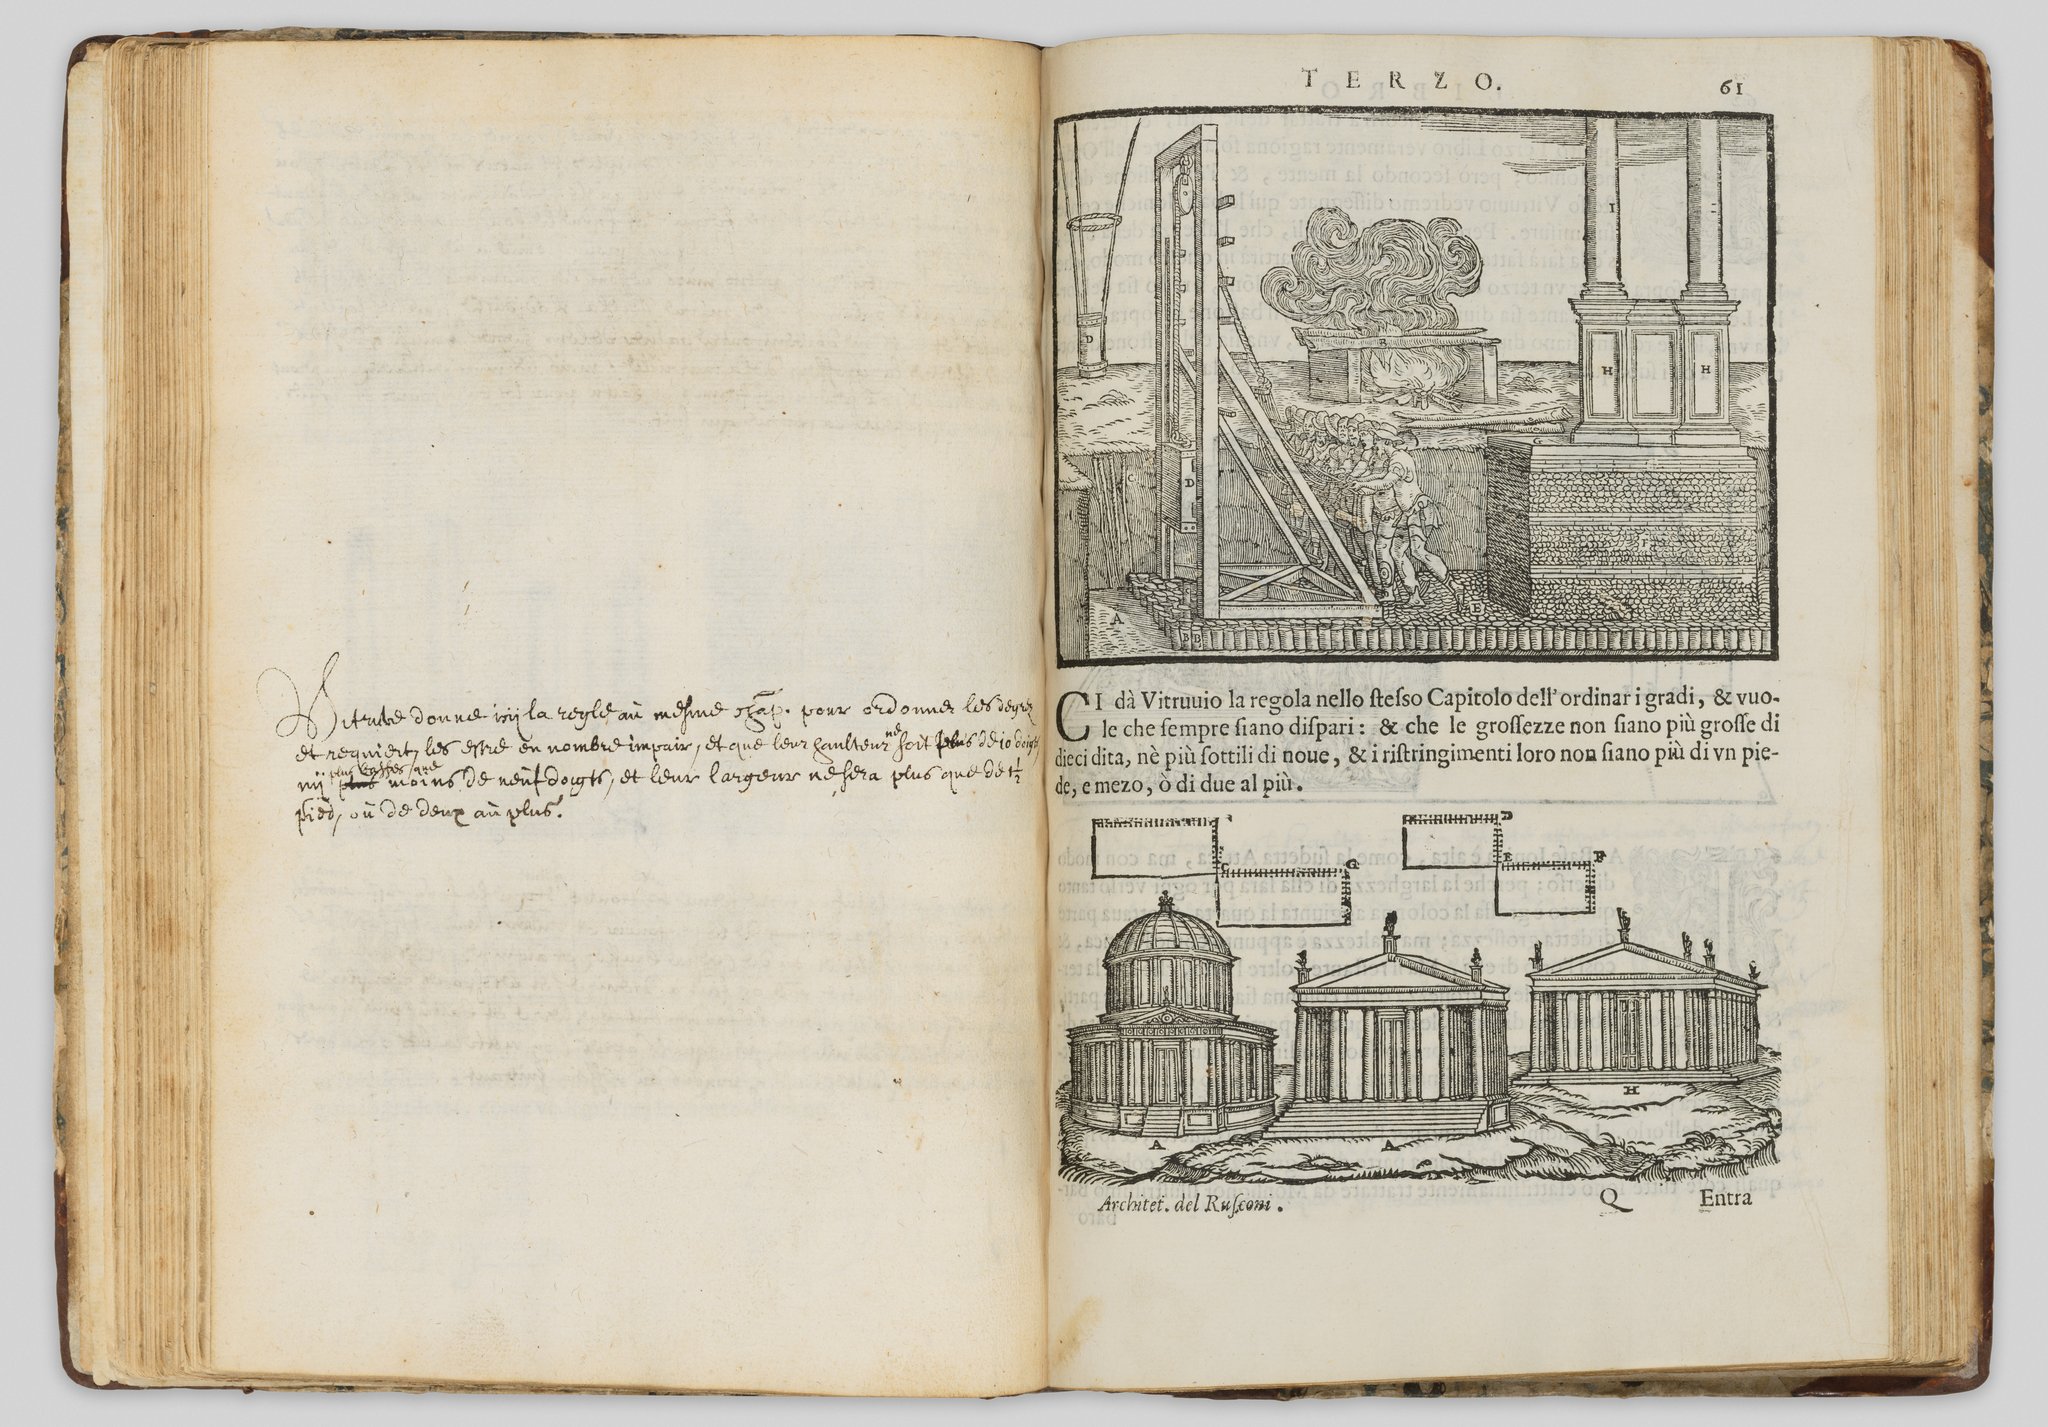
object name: book print ornament architecture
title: I Dieci libri d'architettura di Gio: Antonio Rusconi. Secondo i precetti di Vitruvio, novamenti ristampati, & accresciuti della Prattica degl'Horologi Solari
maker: giovanni antonio rusconi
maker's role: author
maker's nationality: italian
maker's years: 1500-1600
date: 1669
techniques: printing, woodcut